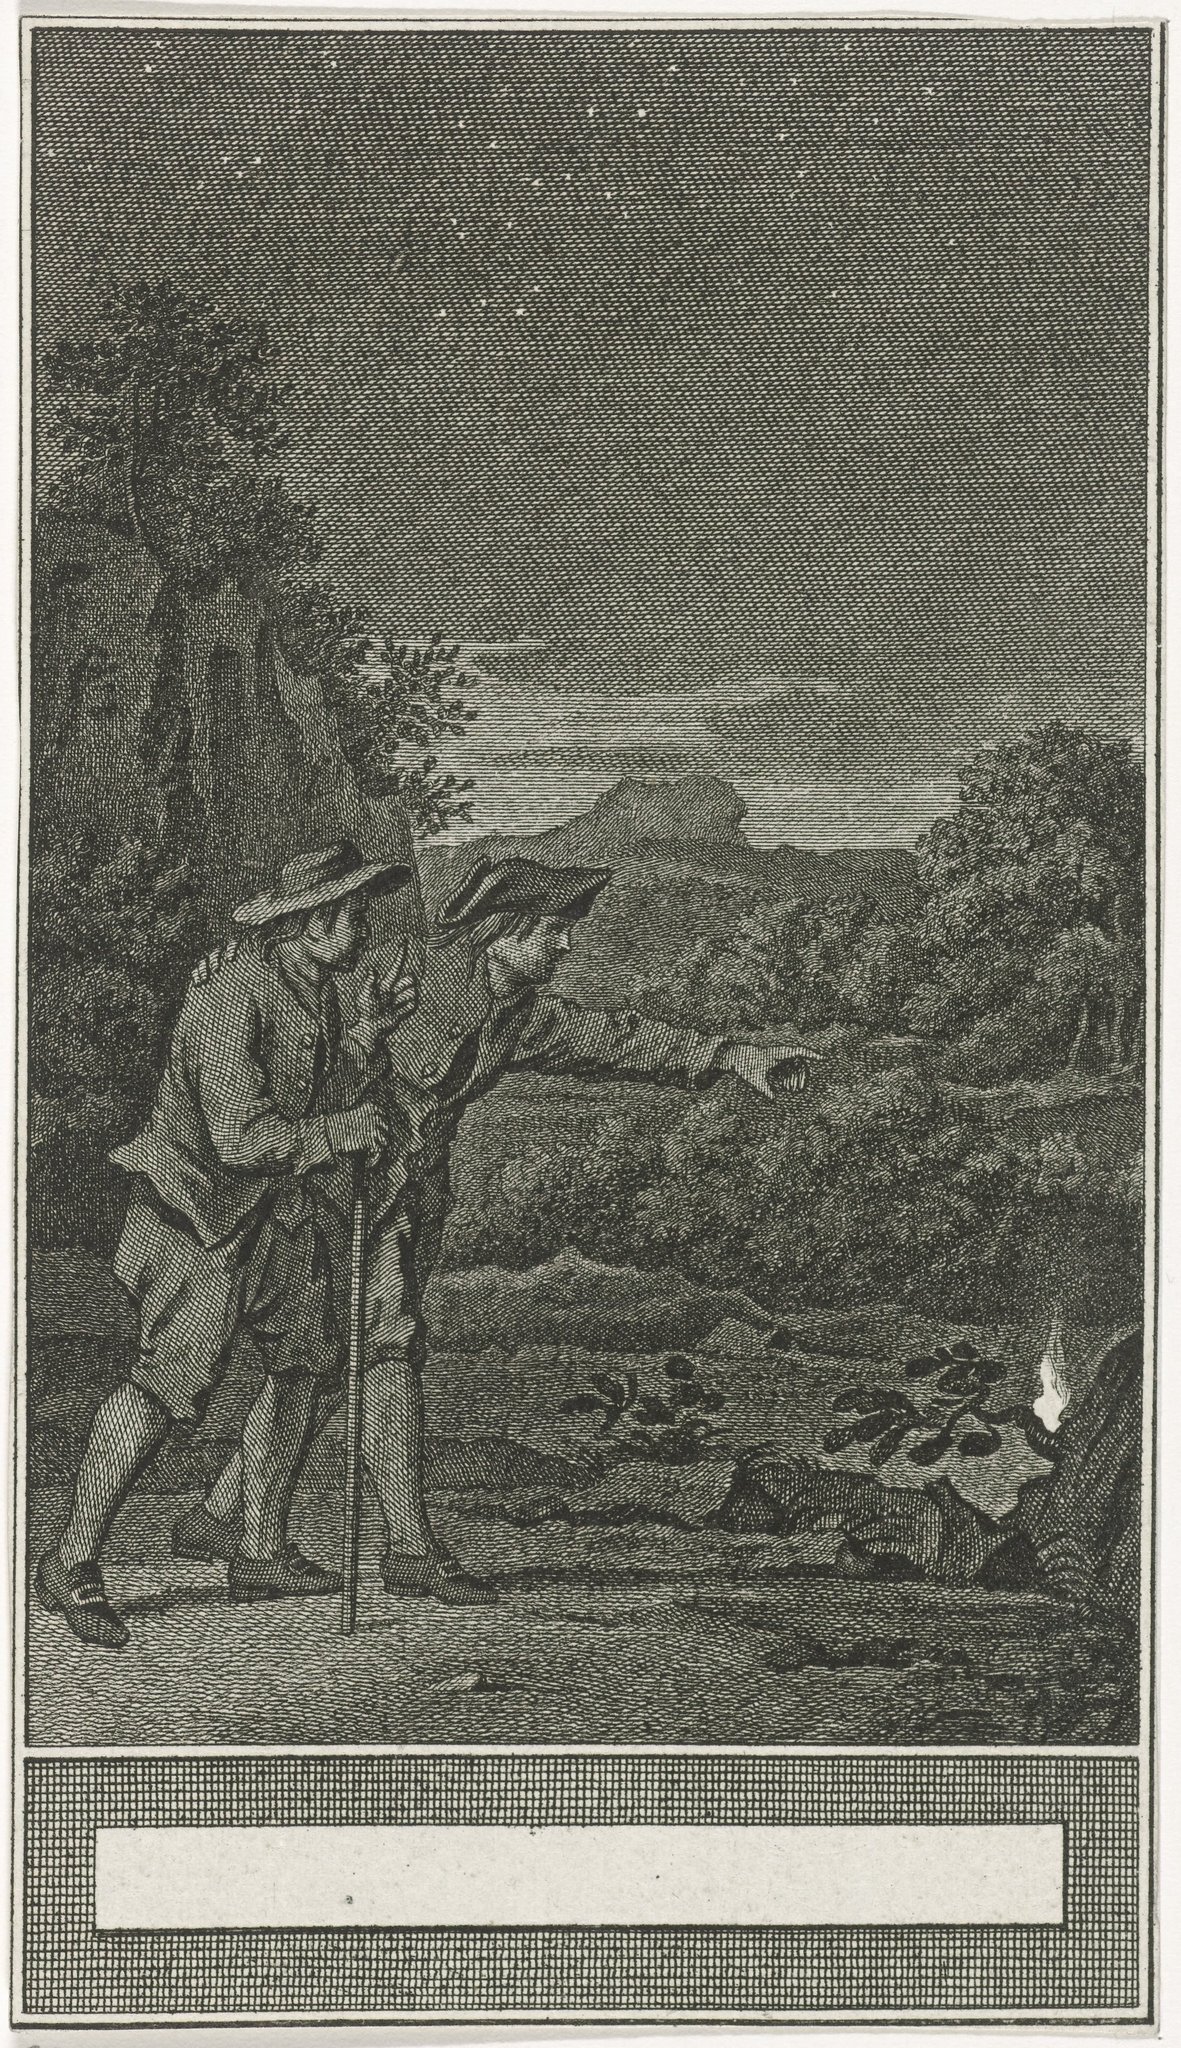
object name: print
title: Twee wandelaars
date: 1778-1785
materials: paper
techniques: etching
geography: amsterdam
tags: walking, hiking (recreation), night, flame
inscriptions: collector's mark: Lugt 2228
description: Latere staat bij: Gellert, Christian Fürchtegott. Fabelen en vertelsels. 3 dln. Amsterdam: Pieter Meyer, 1772-1774. De prenten bij deze publicatie werden later uitgegeven. De exemplaren uitgegeven door de weduwe Jacobus Loveringh & Johannes Allart tussen 1777 en 1778, de exemplaren uitgegeven door alleen Johannes Allart tussen 1778 en 1785.